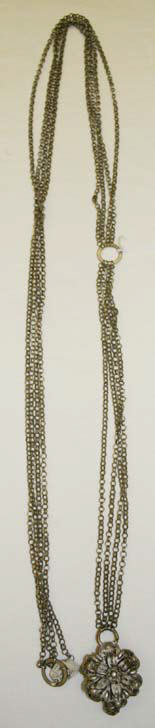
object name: jewelry set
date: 1850-1899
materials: alloy, silver